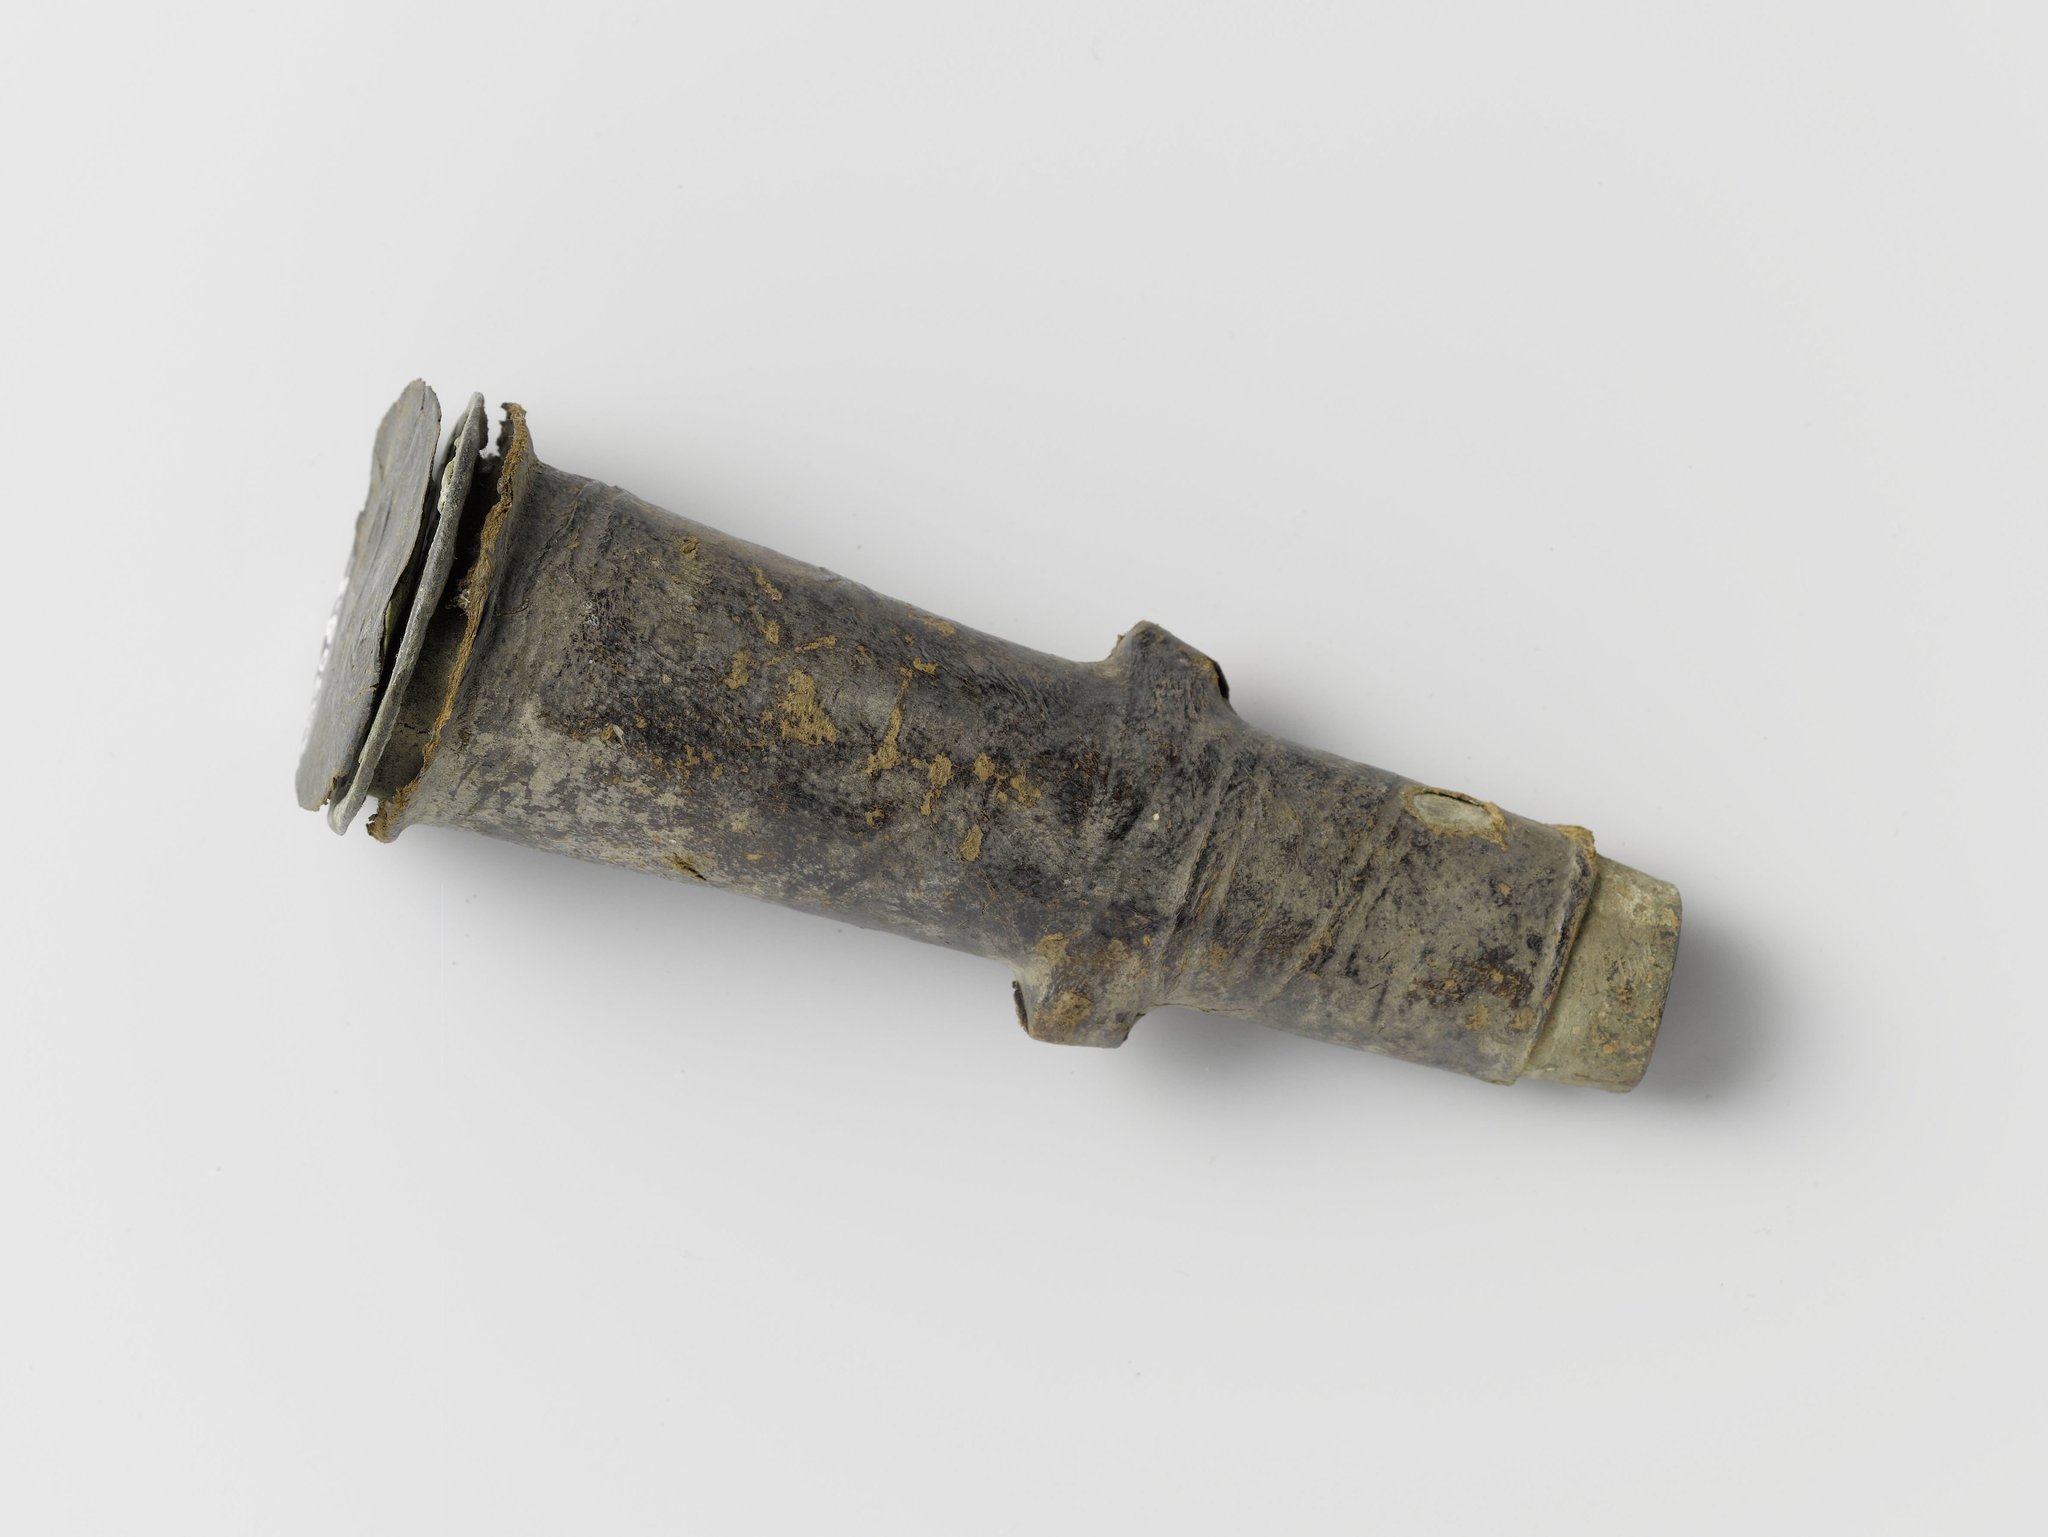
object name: kruitmaat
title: Musketmaat van messing met een leren huls en leren oortjes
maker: Anonymous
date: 1590-1596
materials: brass, leather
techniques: striking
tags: willem barendsz., amsterdam, jacob van heemskerck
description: Musketmaat van messing met een leren huls en leren oortjes. De musketmaat heeft alleen messing aan de onderkant.